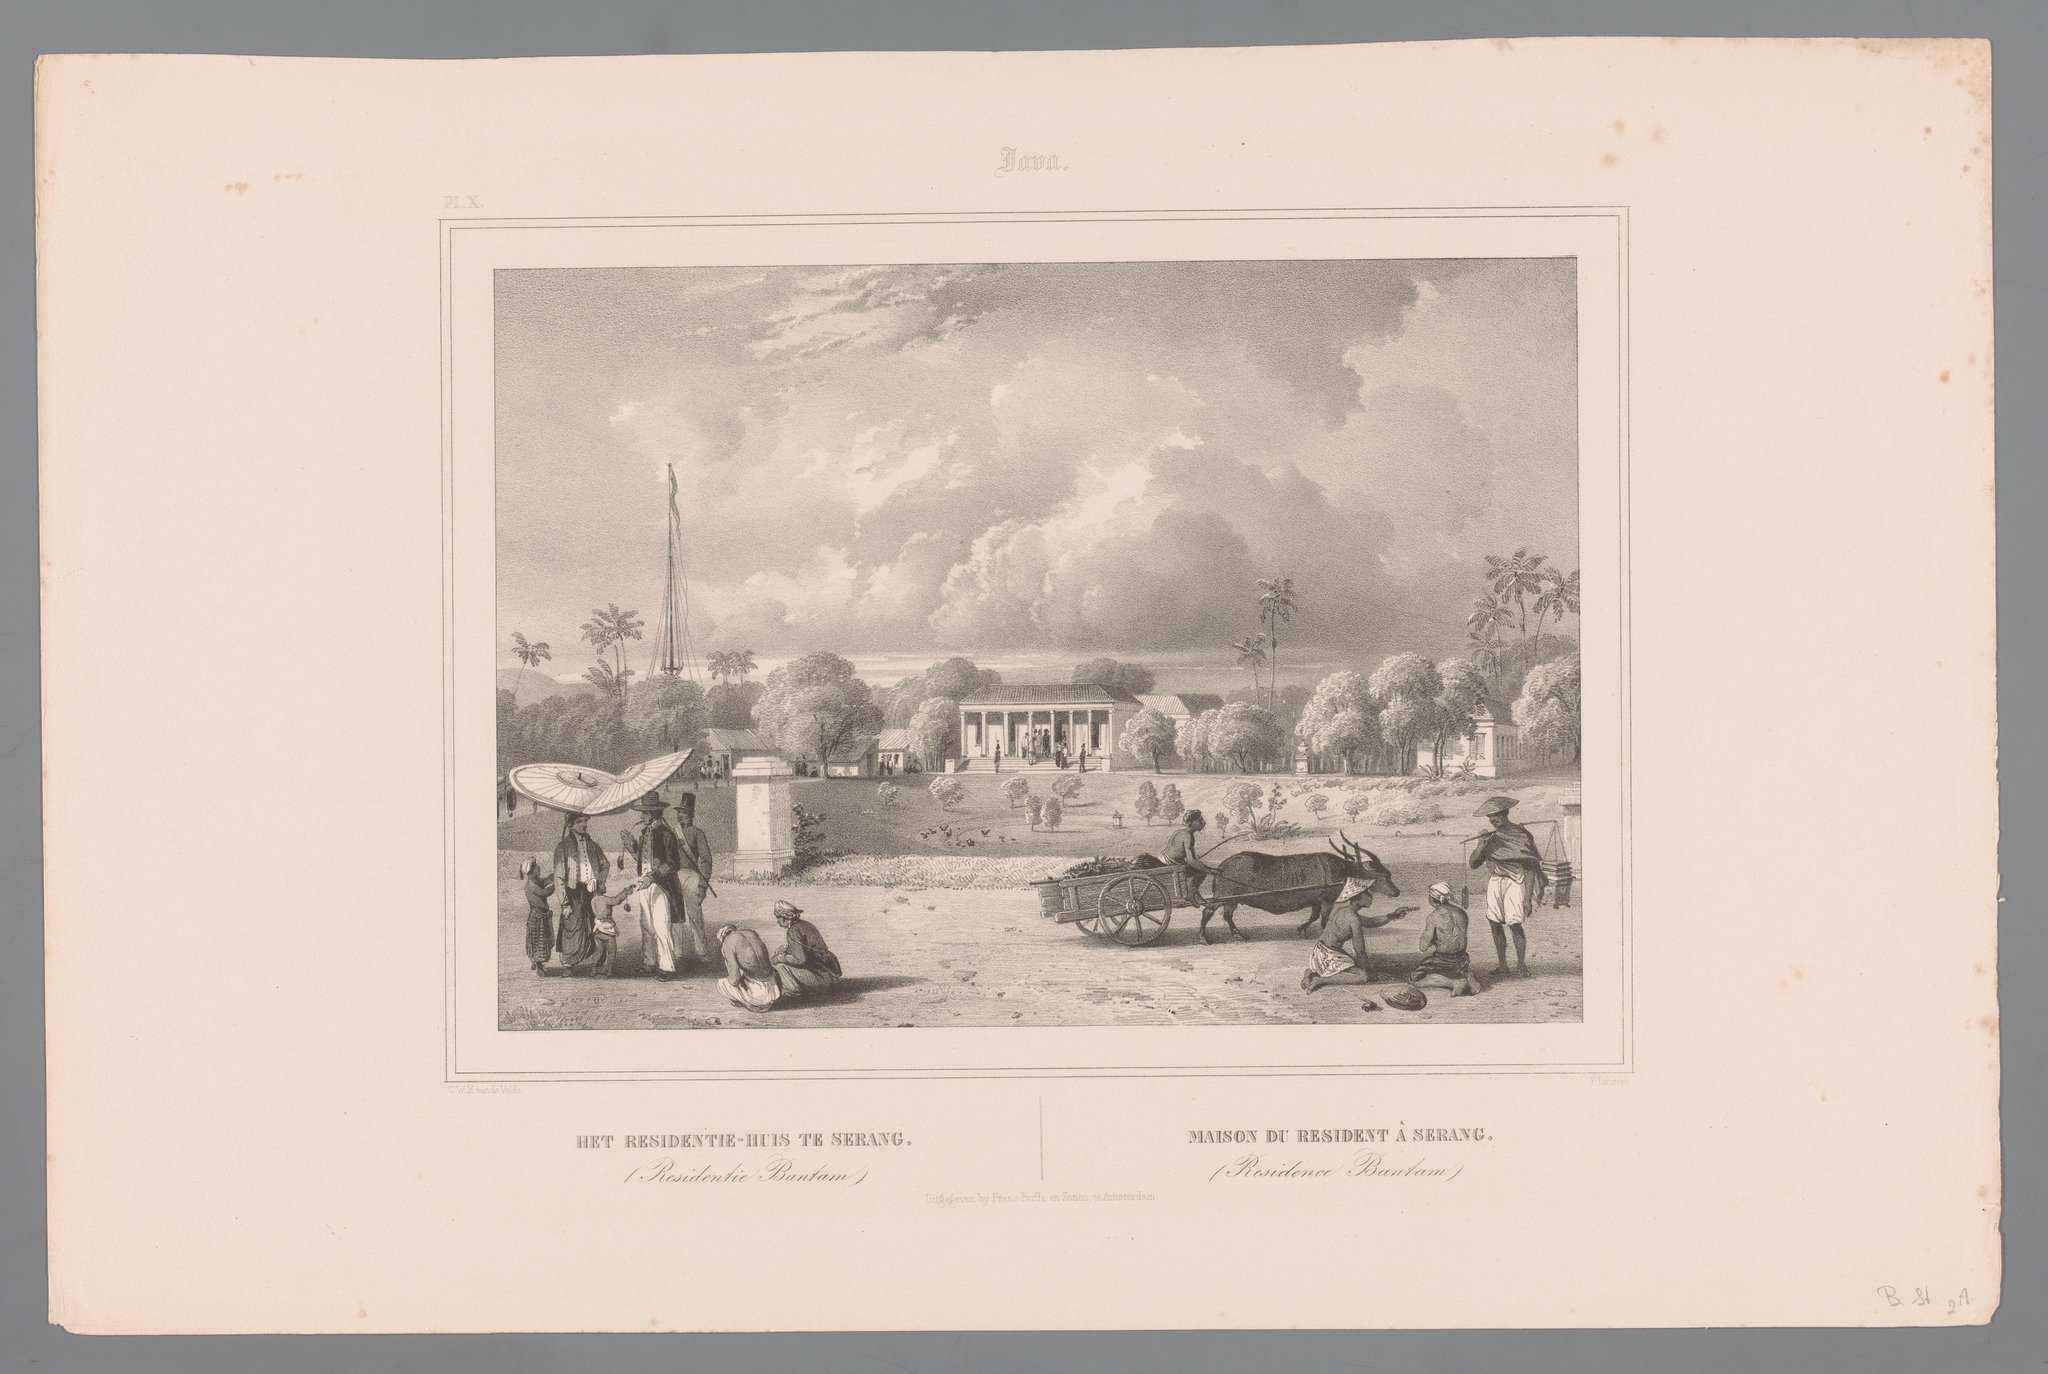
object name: print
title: Gezicht op de residentie te Bantam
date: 1847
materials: paper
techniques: lithograph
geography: amsterdam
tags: two-wheeled, animal-drawn vehicle, civic architecture; edifices; dwellings, parasol, sunshade, city-view in general; 'veduta' (+ city(-scape) with figures, staffage)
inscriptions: collector's mark: Lugt 2228